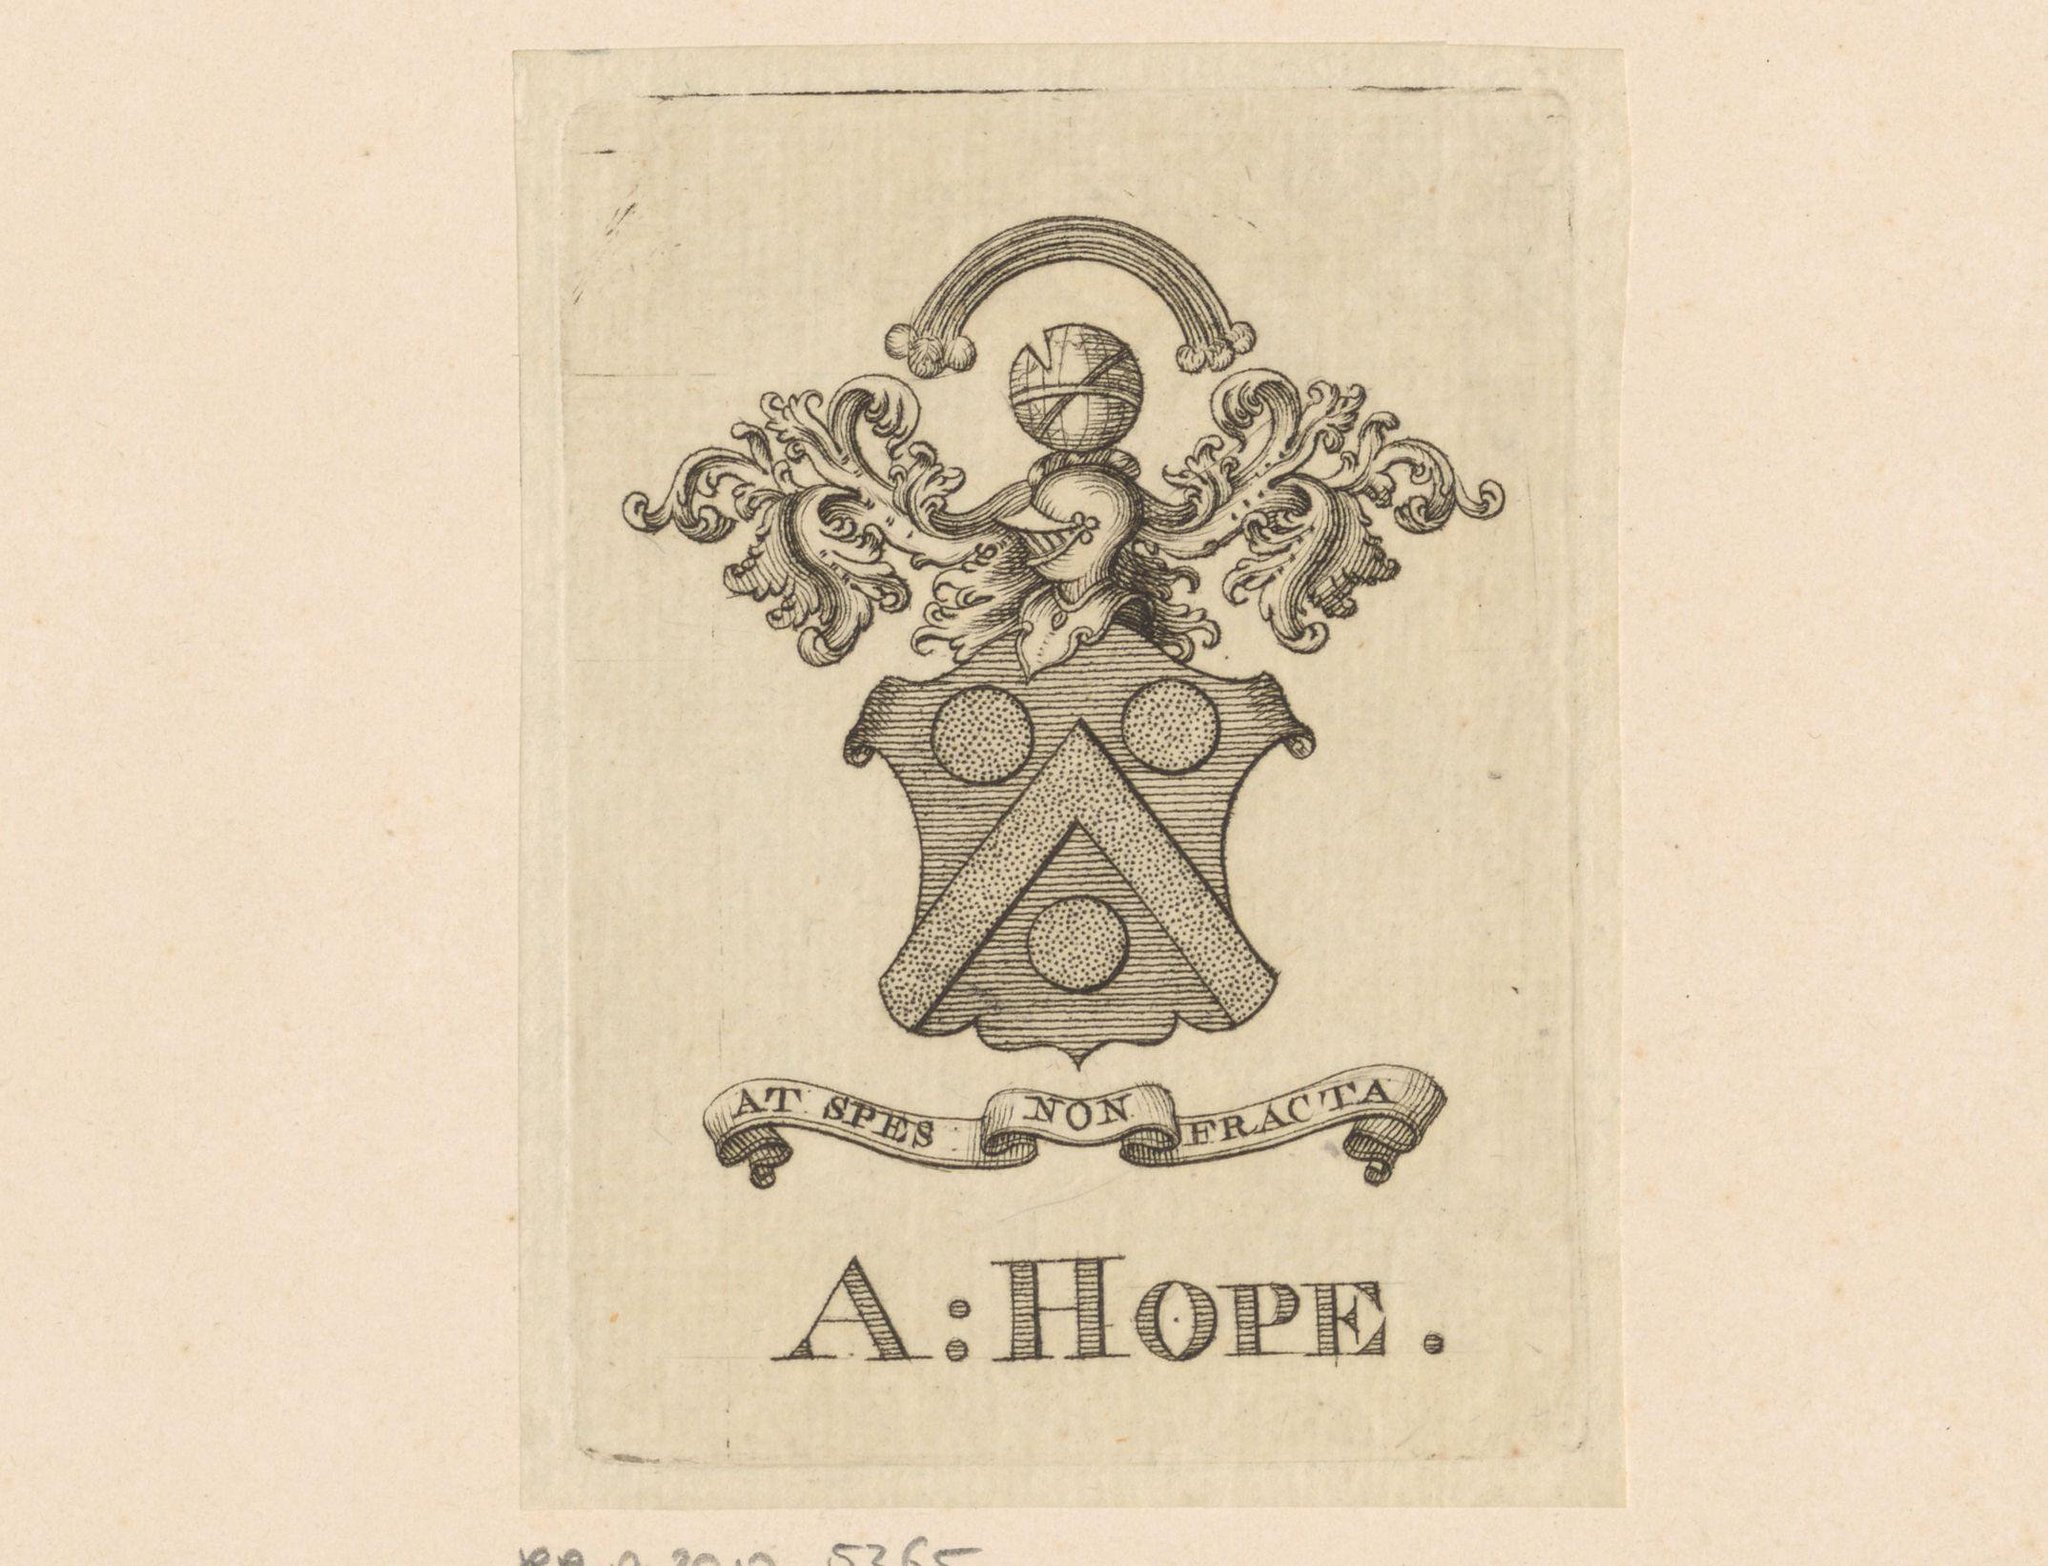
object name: bookplate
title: Ex libris van Archibald Hope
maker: Anonymous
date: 1757-1821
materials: paper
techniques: etching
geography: netherlands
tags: rotterdam, the hague, archibald hope, globe, armorial bearing, heraldry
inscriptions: inscription: ‘Rietstap, 985.’